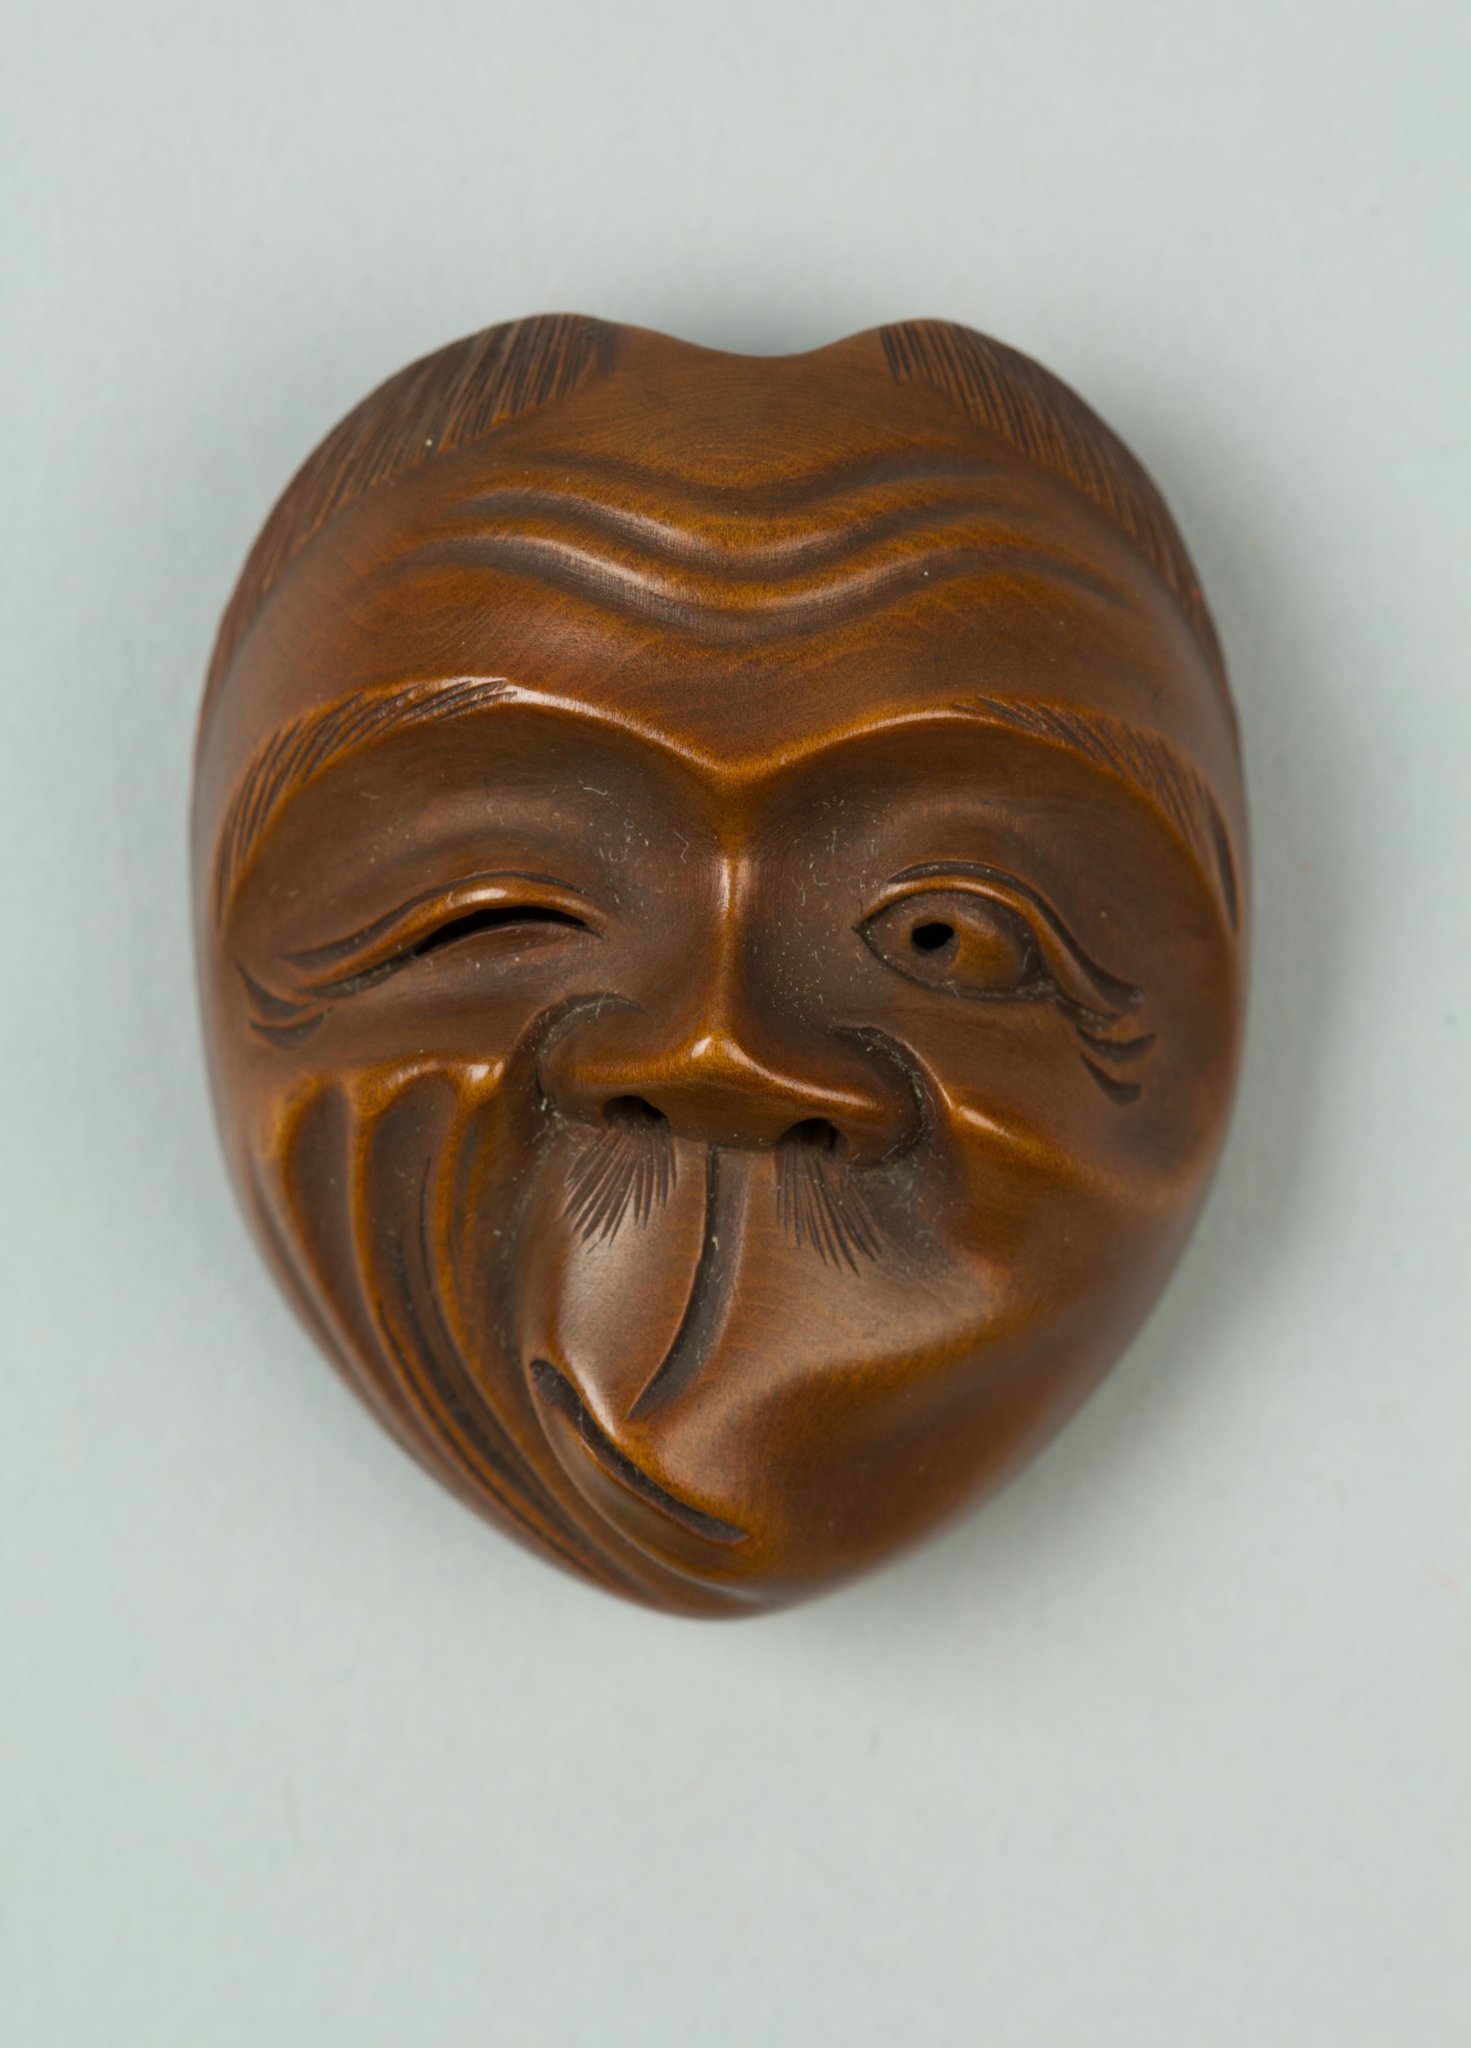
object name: netsuke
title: Netsuke of Usofuki Mask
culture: japanese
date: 1834-1866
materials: wood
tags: masks,faces